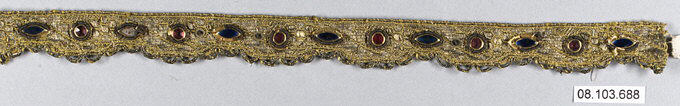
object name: passementerie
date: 1801-1900